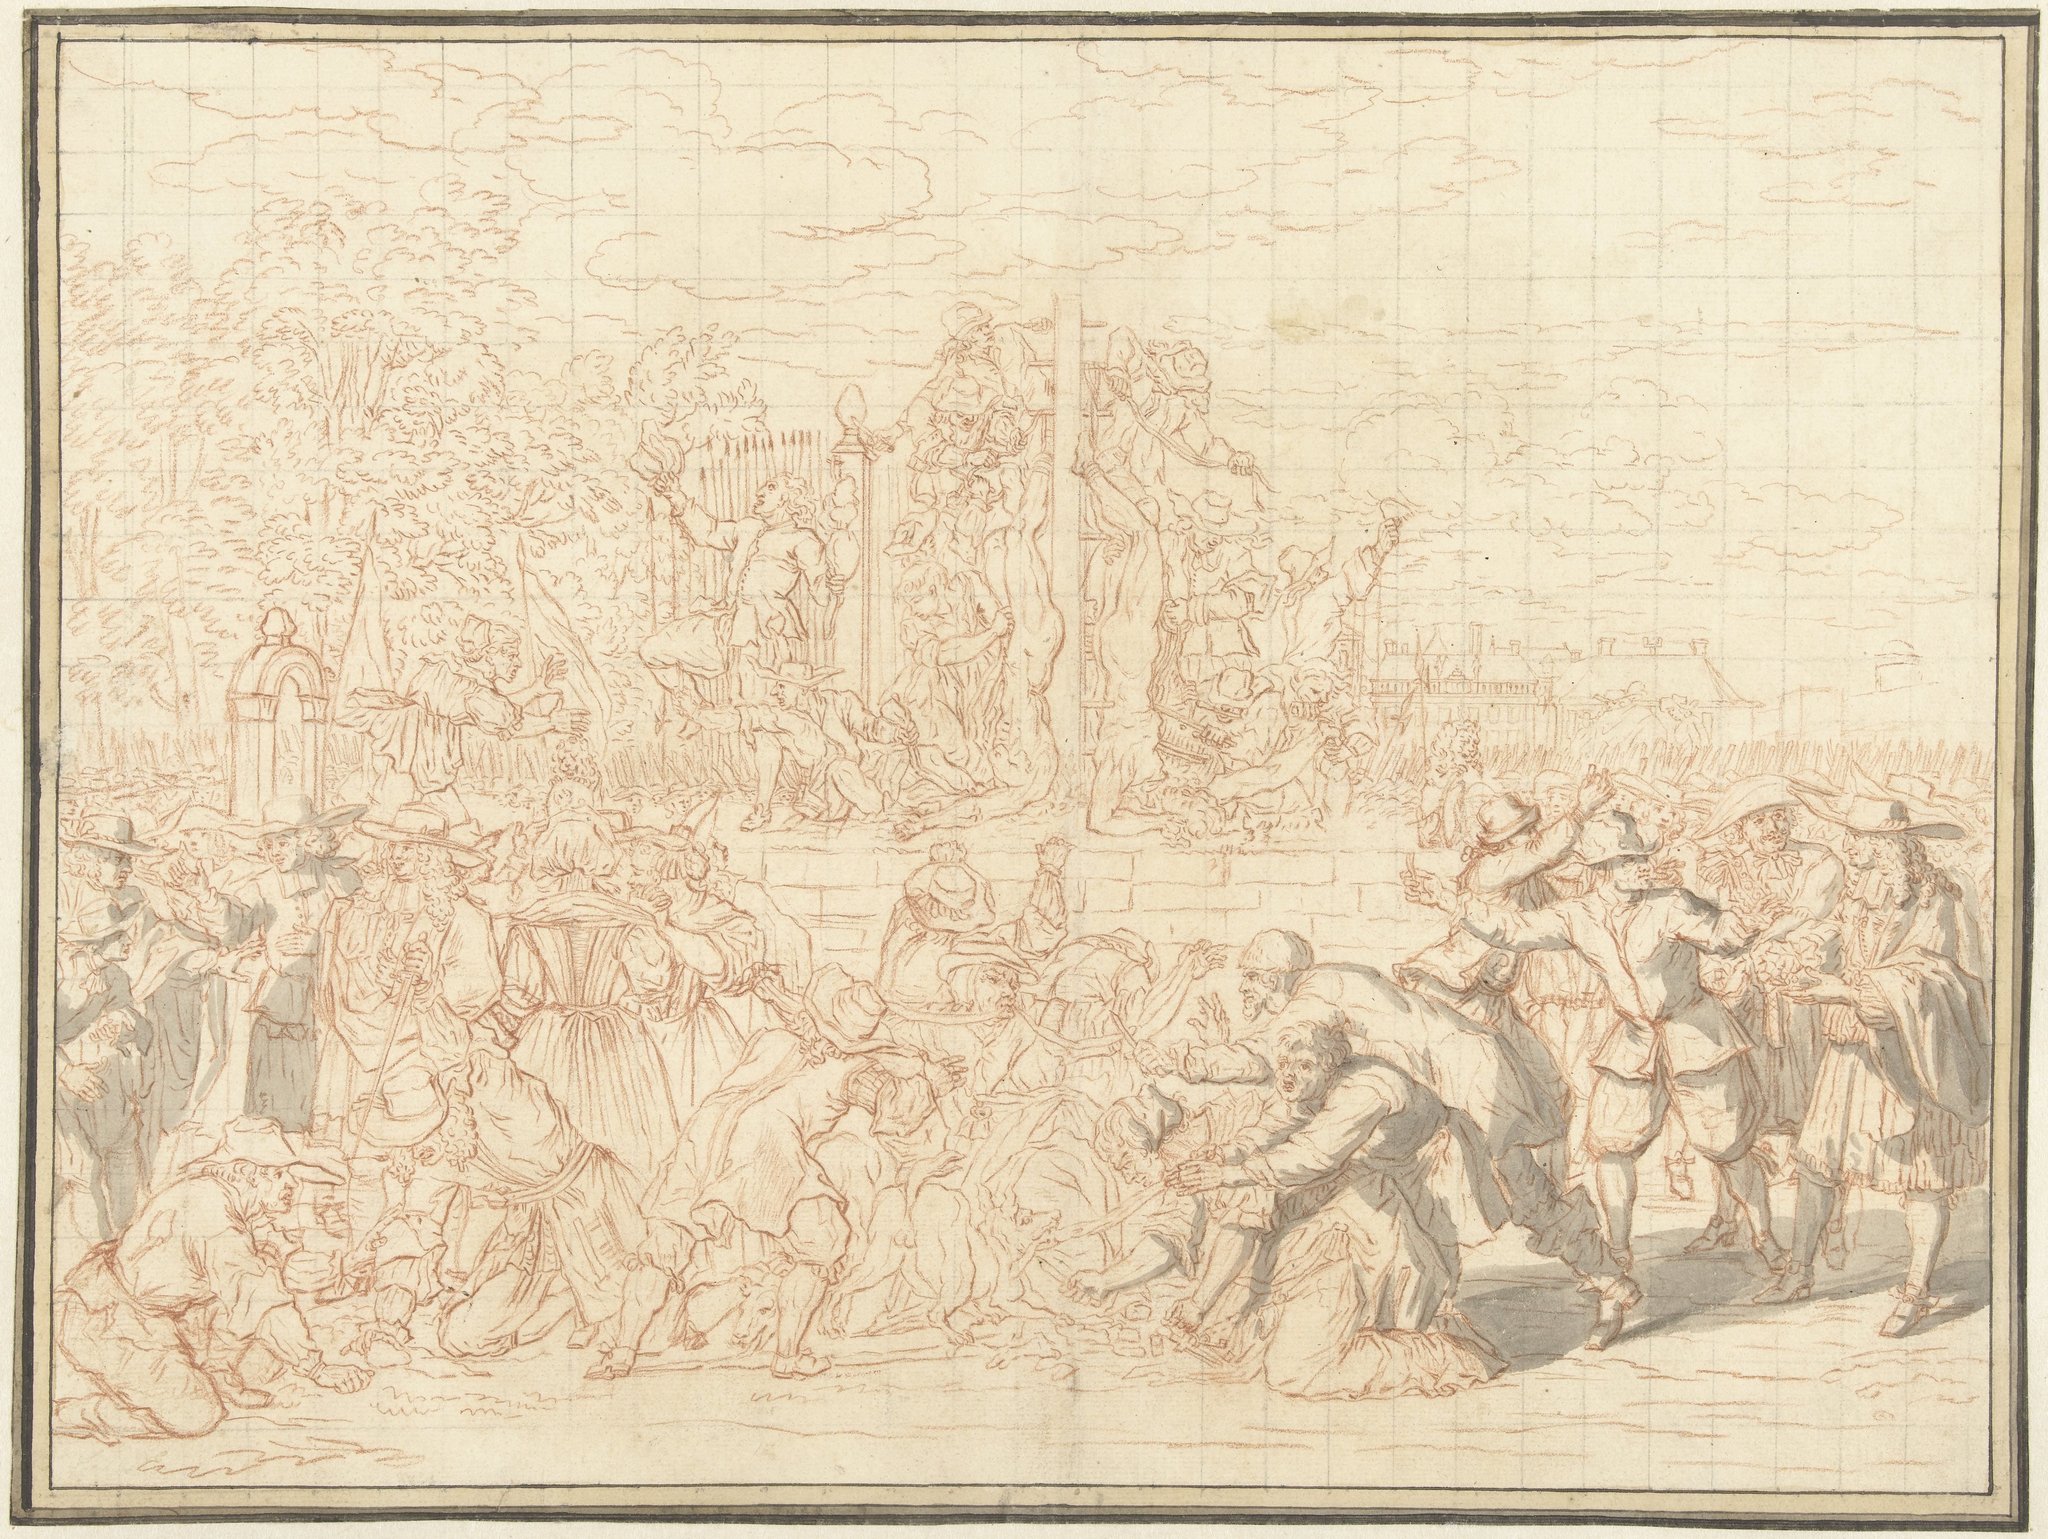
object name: design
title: Verminking van de lichamen van de gebroeders de Witt, 1672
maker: bernard picart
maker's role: draughtsman, print maker, publisher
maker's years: 1673-1733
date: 1728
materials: chalk, paper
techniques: brush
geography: northern netherlands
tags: cornelis de witt, politician, johan de witt, mutilation of the corpse, lynching, attempt, political murder, violent death, being killed; being mishandled and maltreated; seeking death (+ death by lynching), the hague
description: Naar de prent van Romeyn de Hooghe (FMH 2401).. Ontwerptekening voor illustratie in: J. le Clerc, Histoire des Provinces-Unies des Pays-Bas, Amsterdam 1723-1728, 4 delen, dl. III, p. 430.